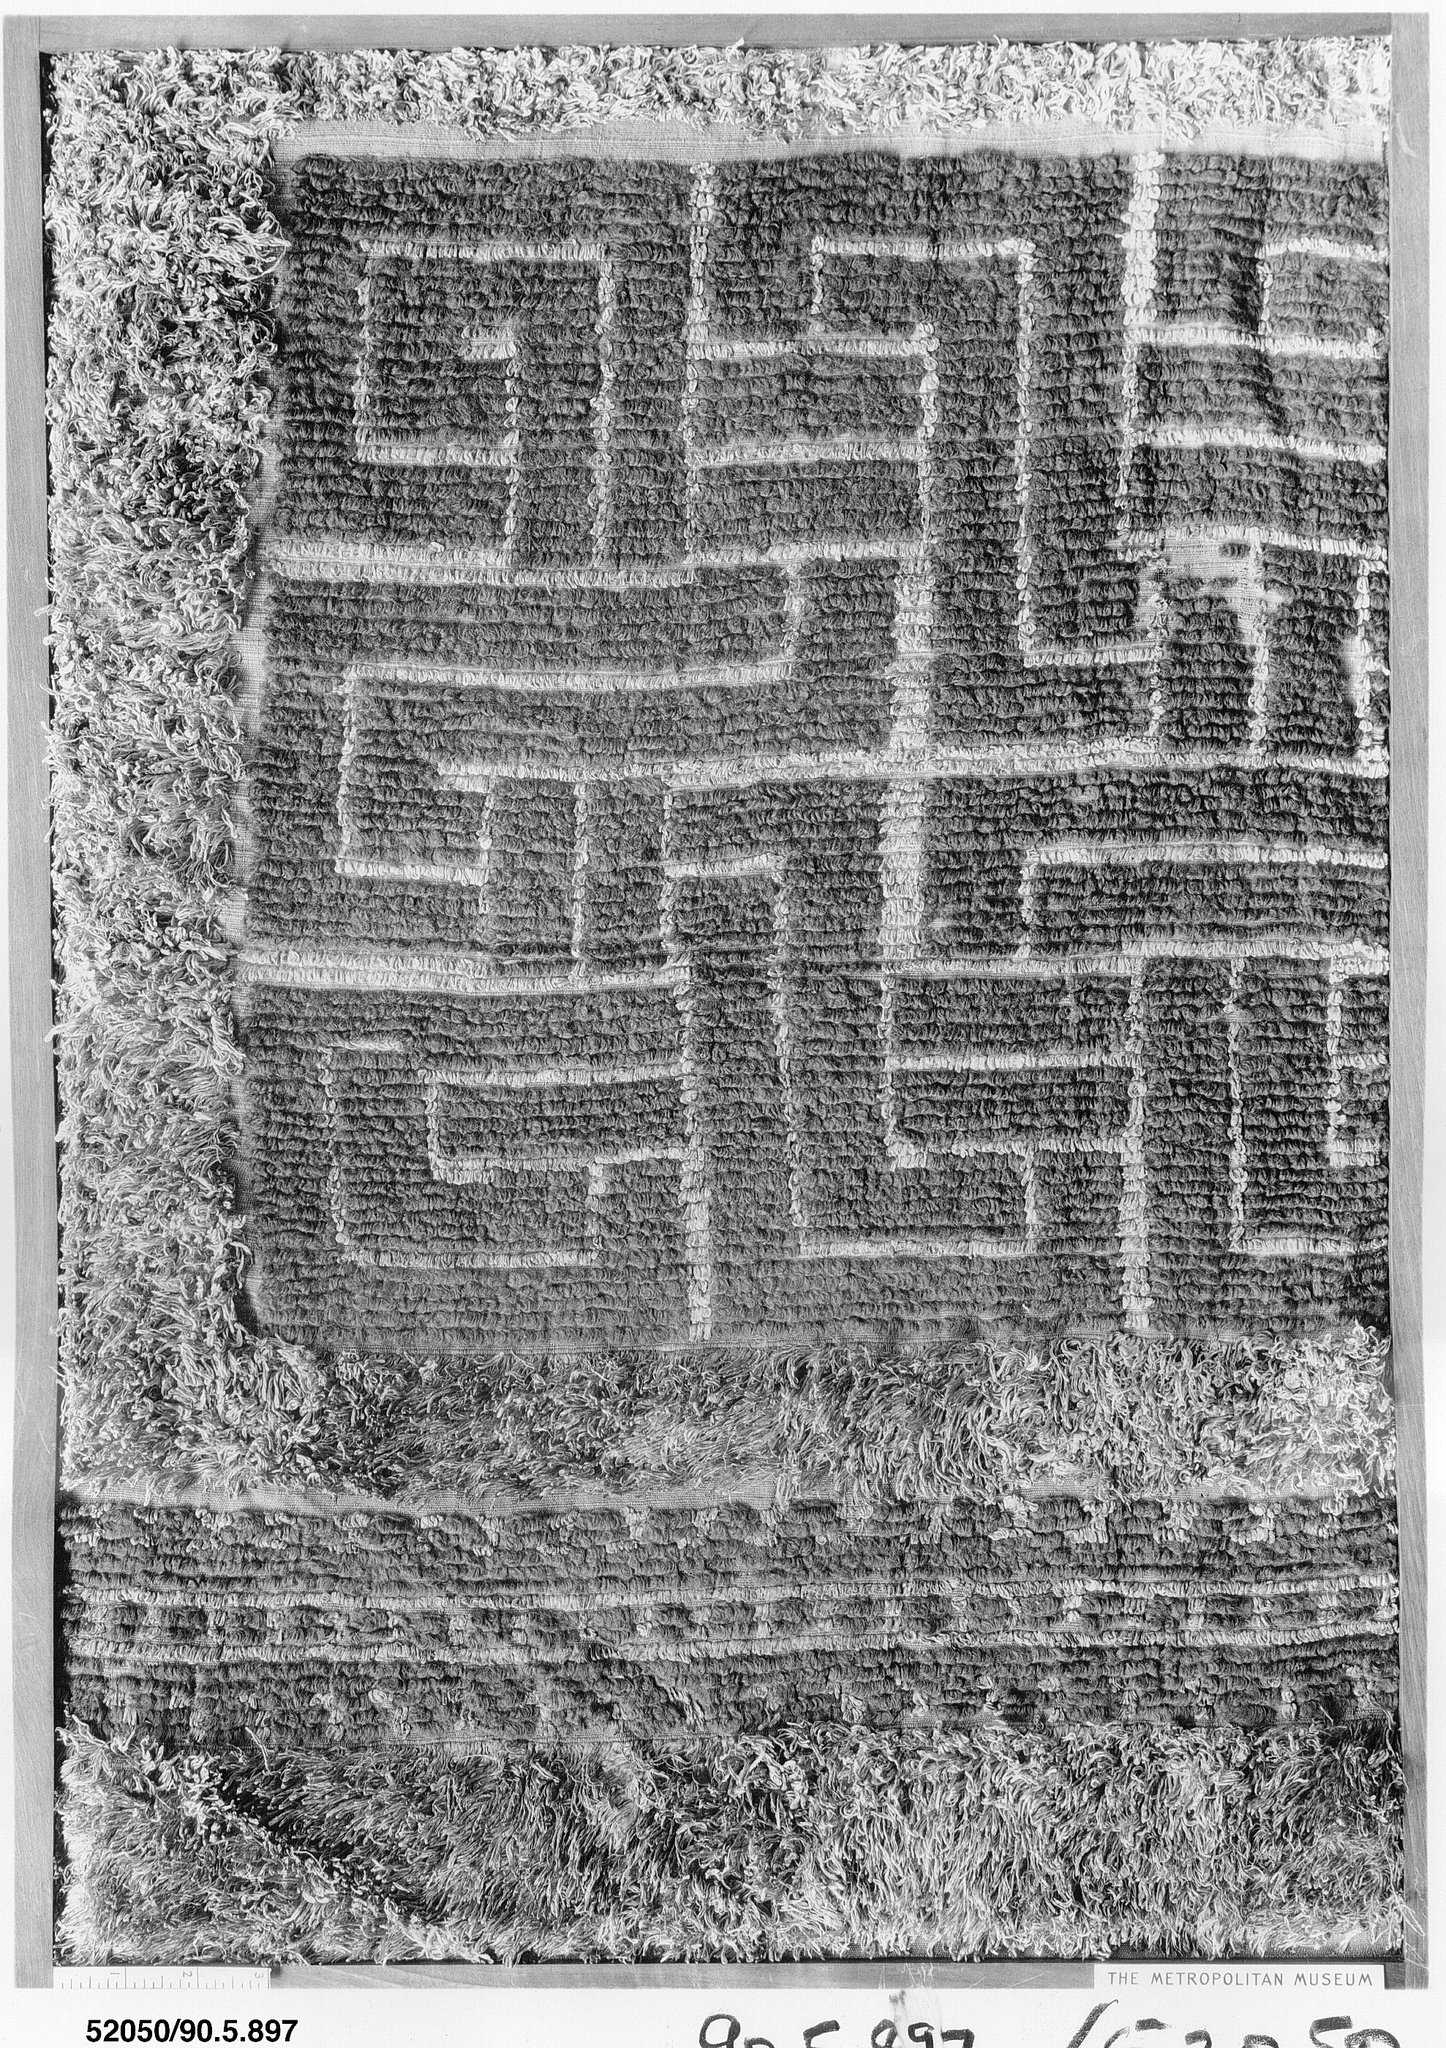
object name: textile fragment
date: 201-400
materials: linen, wool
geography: egypt